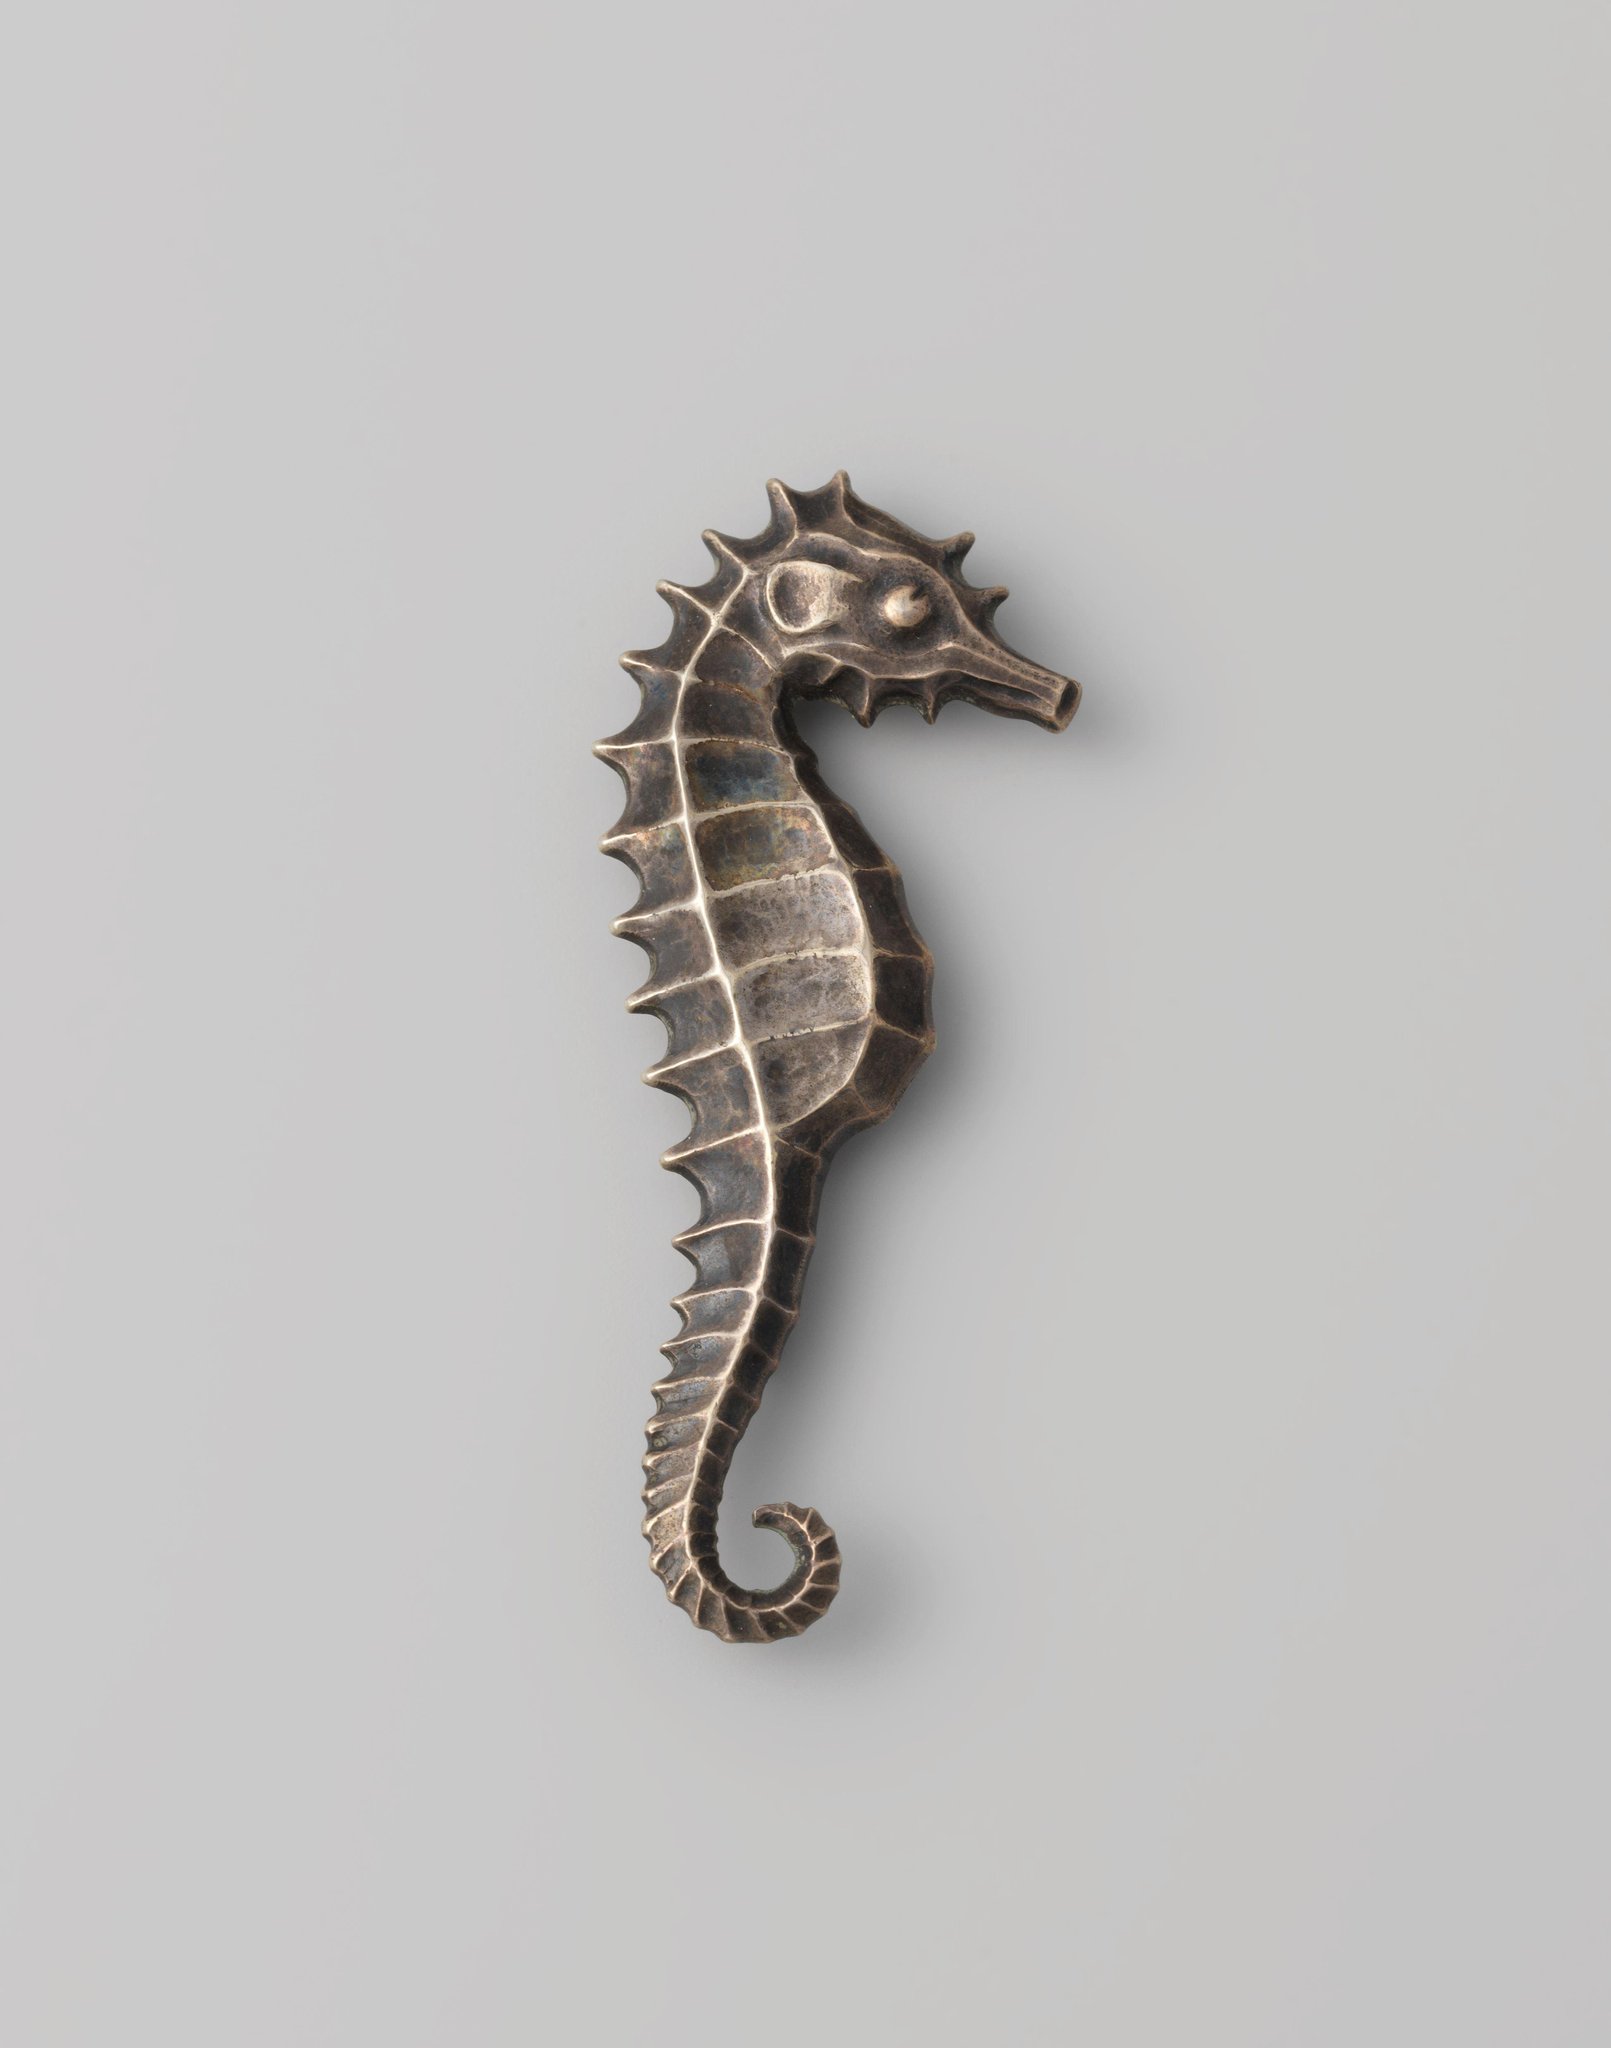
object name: brooch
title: Broche van zilver 'Zeepaard'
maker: Anonymous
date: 1930-1940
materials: silver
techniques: hammering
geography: netherlands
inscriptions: : ‘I’, maker's mark: ‘MM’